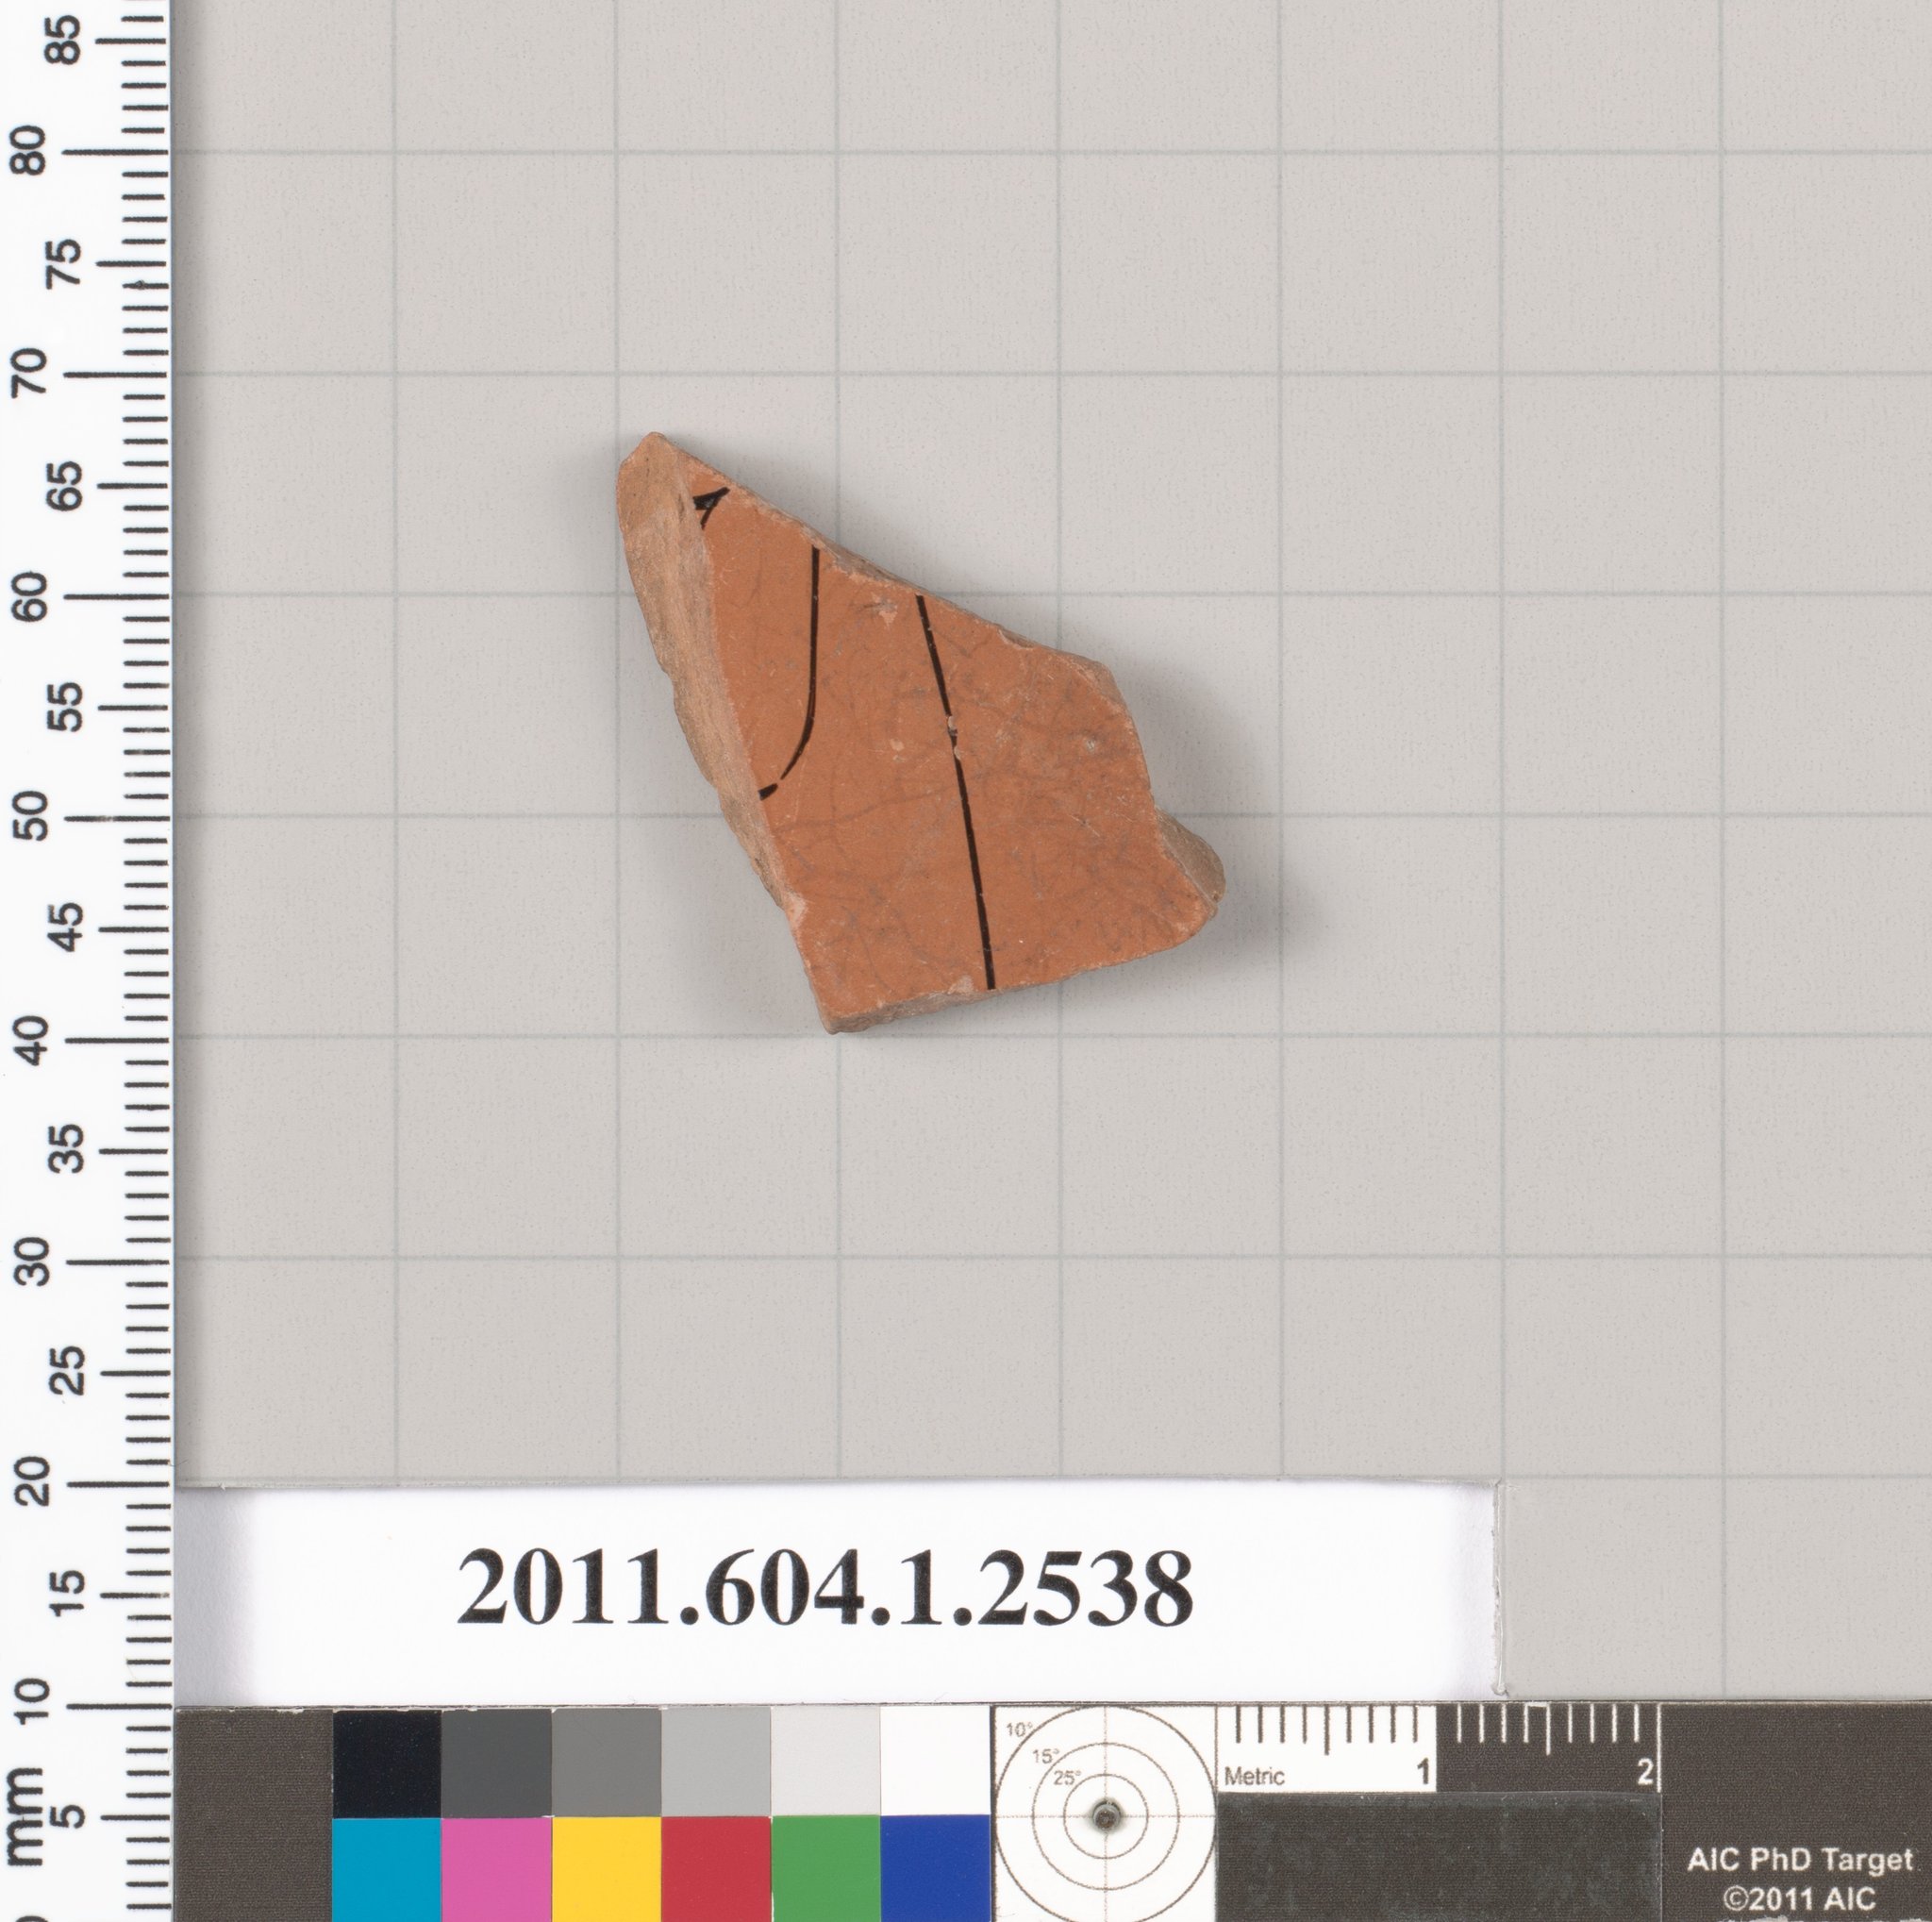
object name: kylix fragment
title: Terracotta fragment of a kylix (drinking cup)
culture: greek, attic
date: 490-480 BCE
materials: terracotta